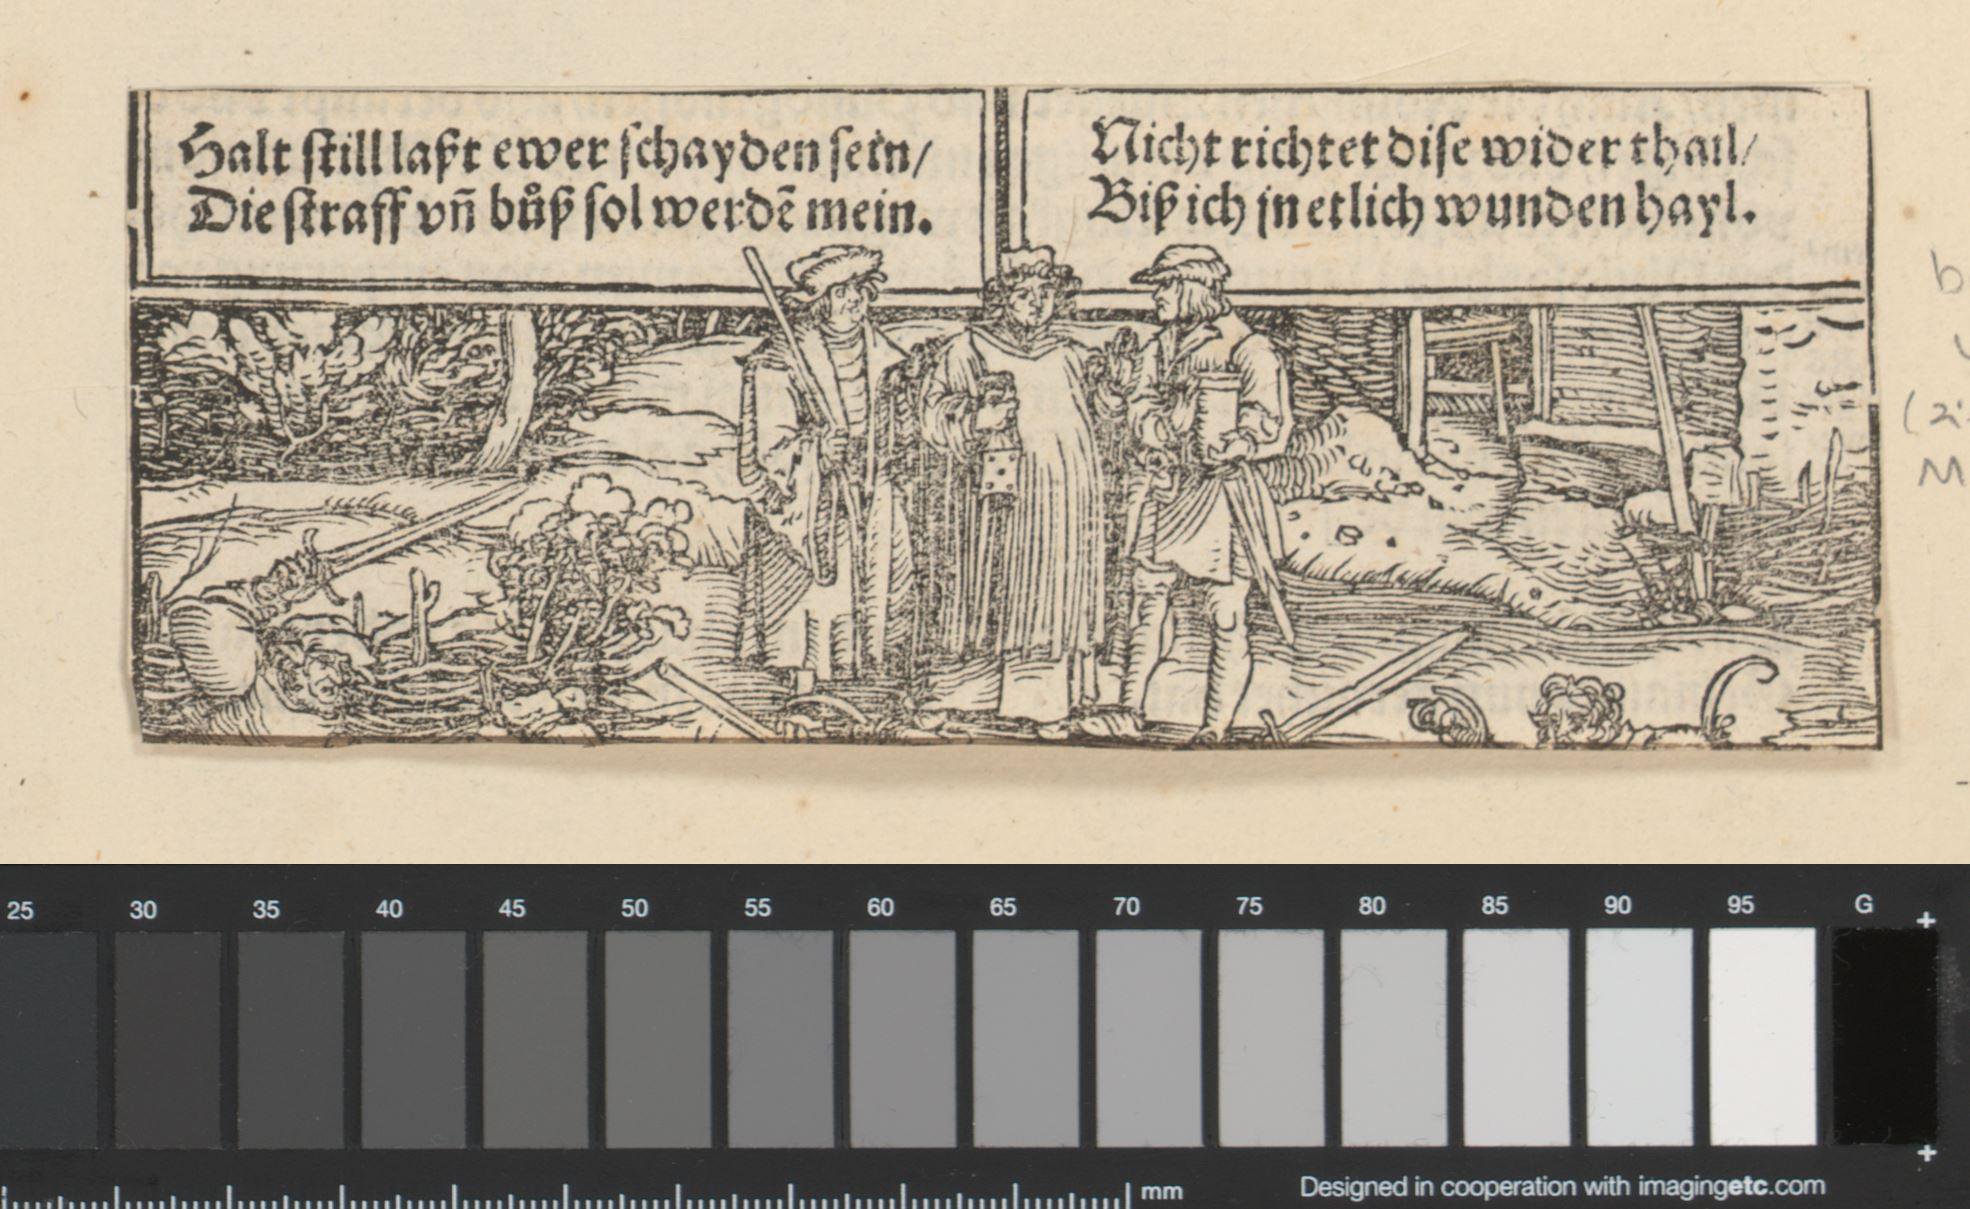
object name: book illustration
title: Drie mannen bij een vechtpartij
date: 1514-1531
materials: paper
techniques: letterpress printing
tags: meeting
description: Deze prent is gebruikt in: Cicero, Marcus Tulius. Officia M.T.C. Ein Buch so Marcus Tullius Cicero der Römer zu seynem (...). [Vertaald uit het Latijn door] Johann von Schwarzenberg. Augsburg: Heinrich Steiner, 1531.